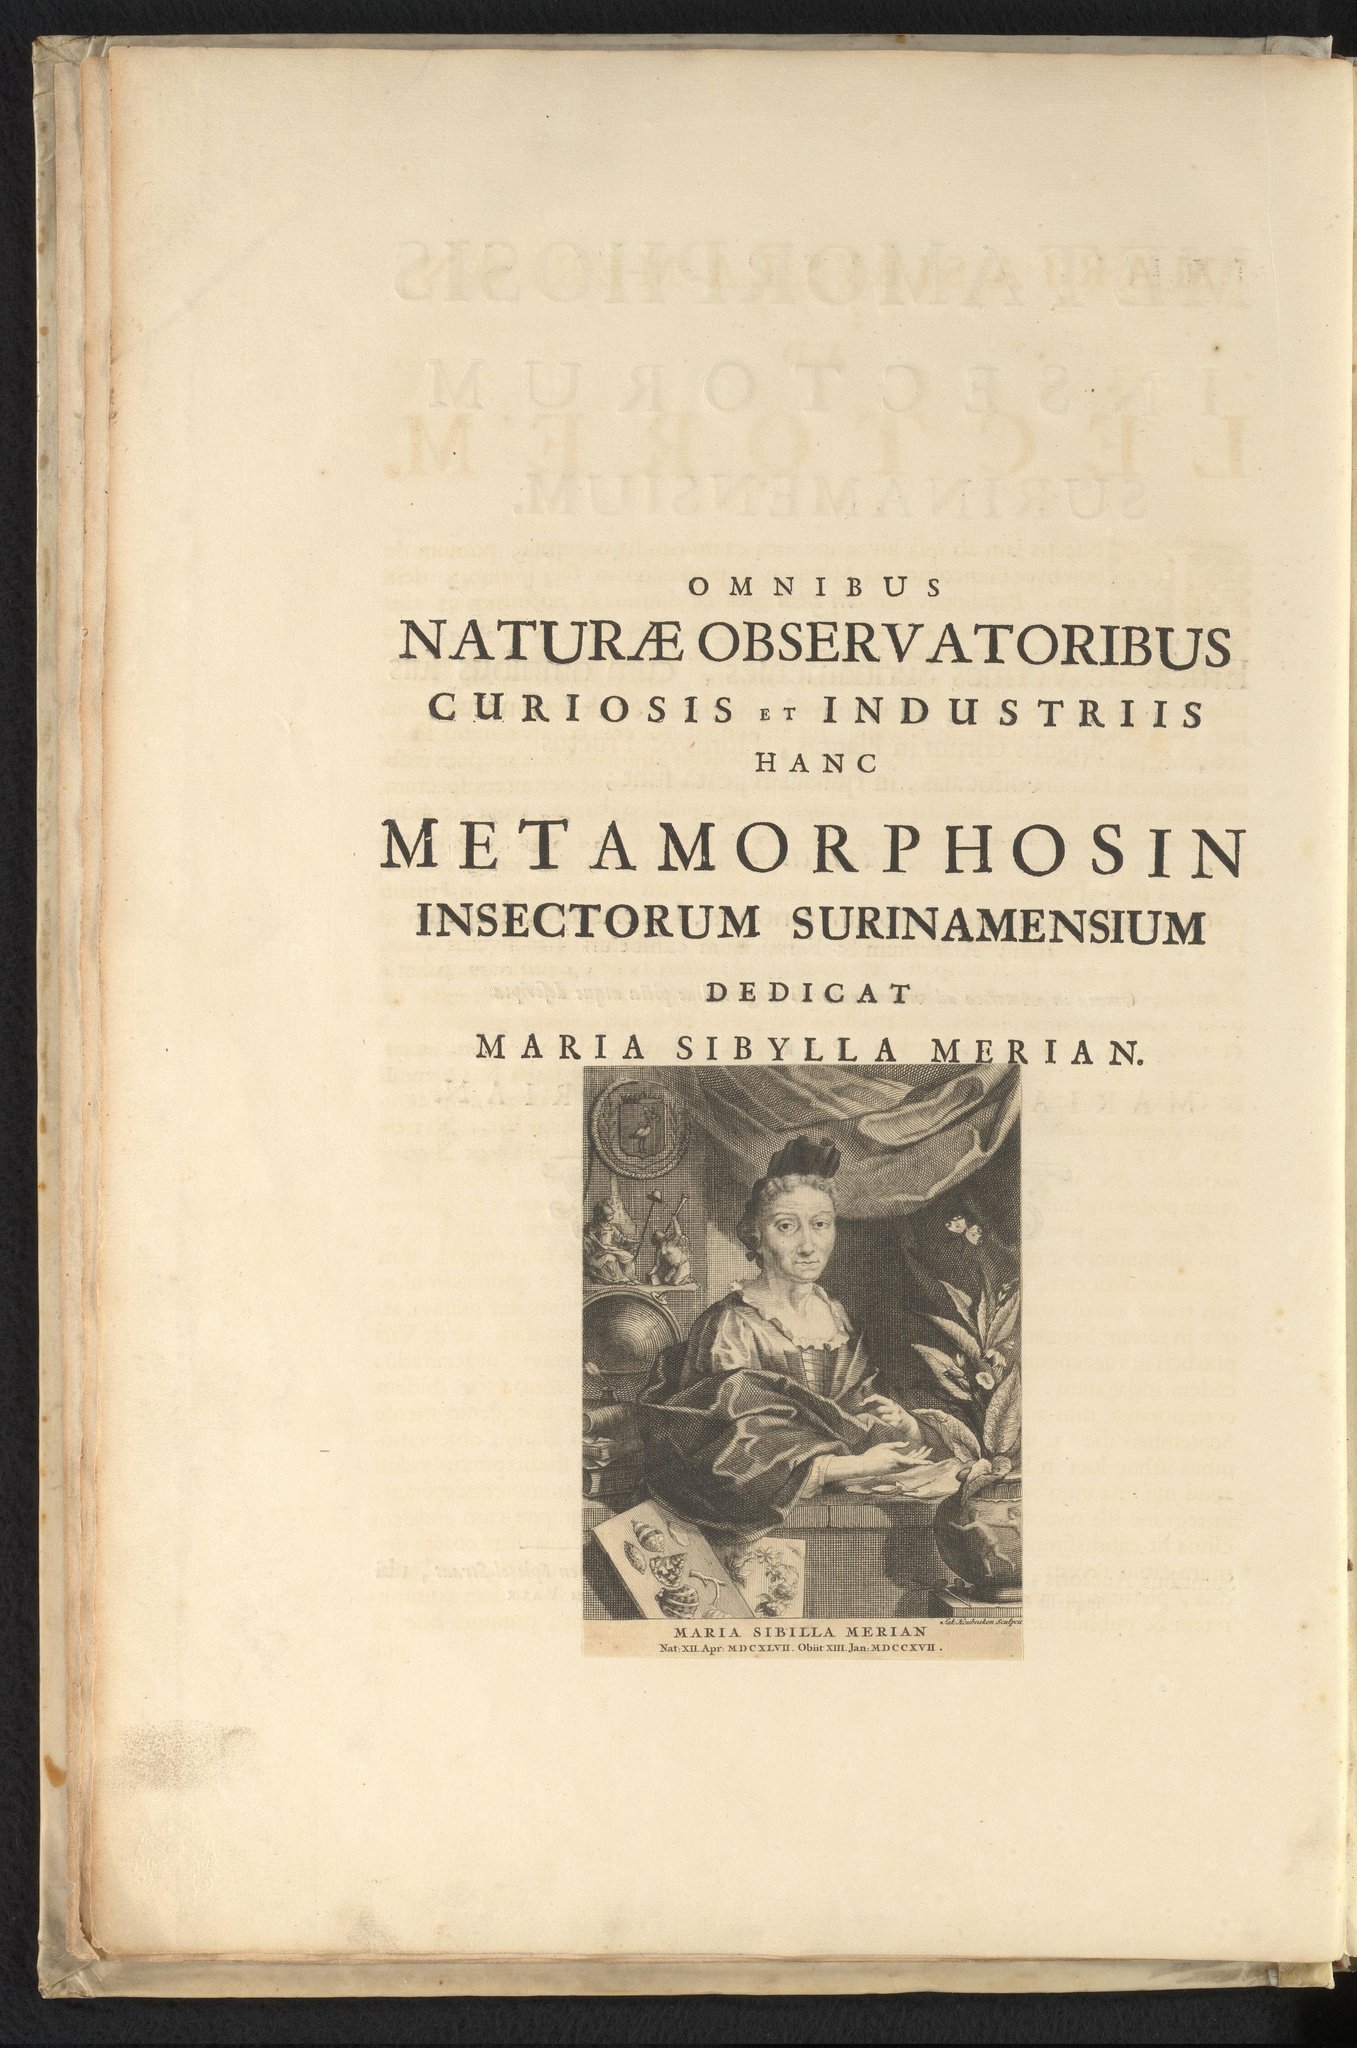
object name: print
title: Portret van Maria Sibylla Merian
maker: jacob houbraken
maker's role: draughtsman, print maker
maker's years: 1698-1780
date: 1708-1780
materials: paper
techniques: engraving, etching, letterpress printing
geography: amsterdam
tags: amsterdam, painter, draughtsman, maria sibylla merian, historical persons - bb - woman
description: Prent maakt deel uit van een boek. Het portret is in het boek geplakt op de versozijde van de titelpagina.